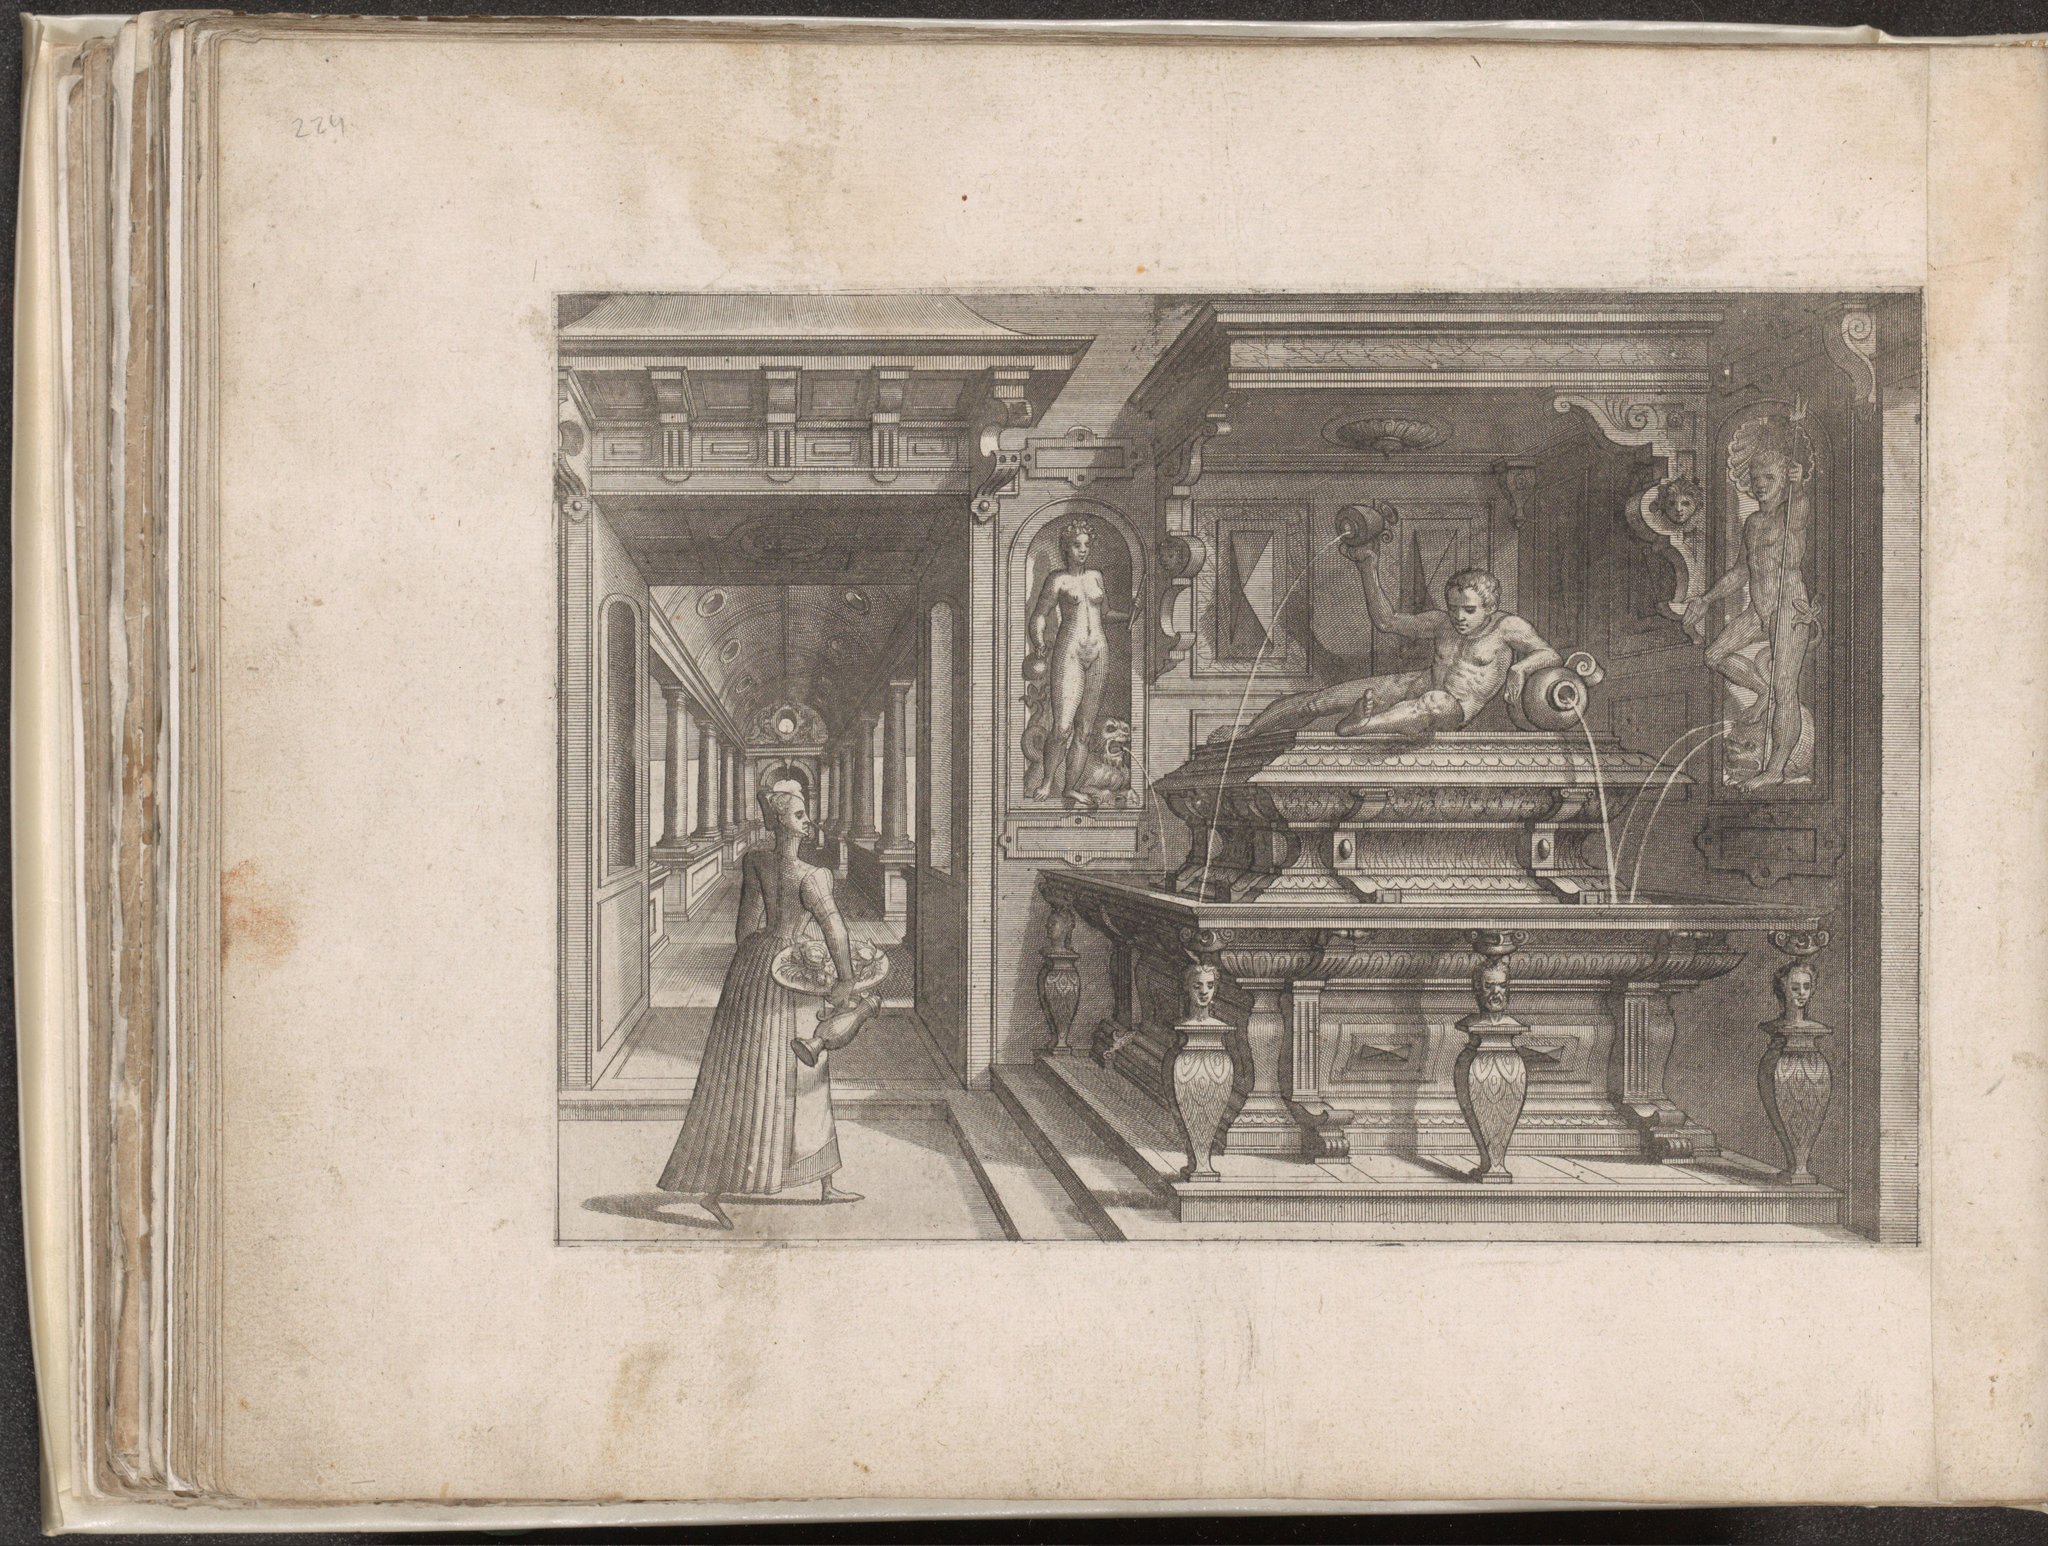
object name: print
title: Artis Perspectivae (...)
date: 1568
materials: paper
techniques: etching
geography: antwerp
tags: standing figure (canon, proportions) - aa - female human figure, ornamental fountain, civic architecture; edifices; dwellings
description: Een hoekfontein in de vorm van een tombe bekroond met het beeld van een man, die tegen een kruik leunt waar water uitkomt. Links een staande vrouw met een schaal onder de arm en een kruik in de hand. Achter haar zicht in een galerij. Deze prent maakt deel uit van een album.